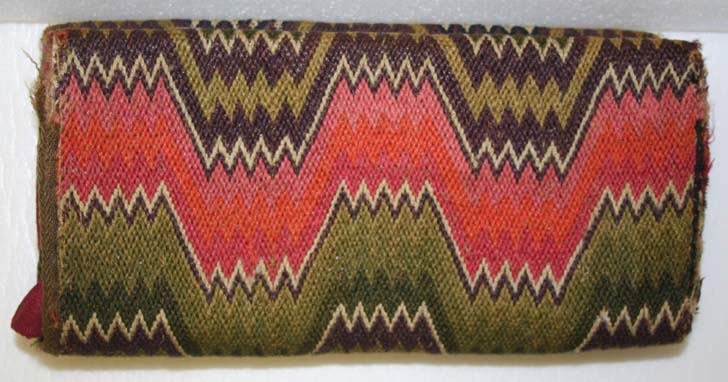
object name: purse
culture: british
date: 1775-1800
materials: wool